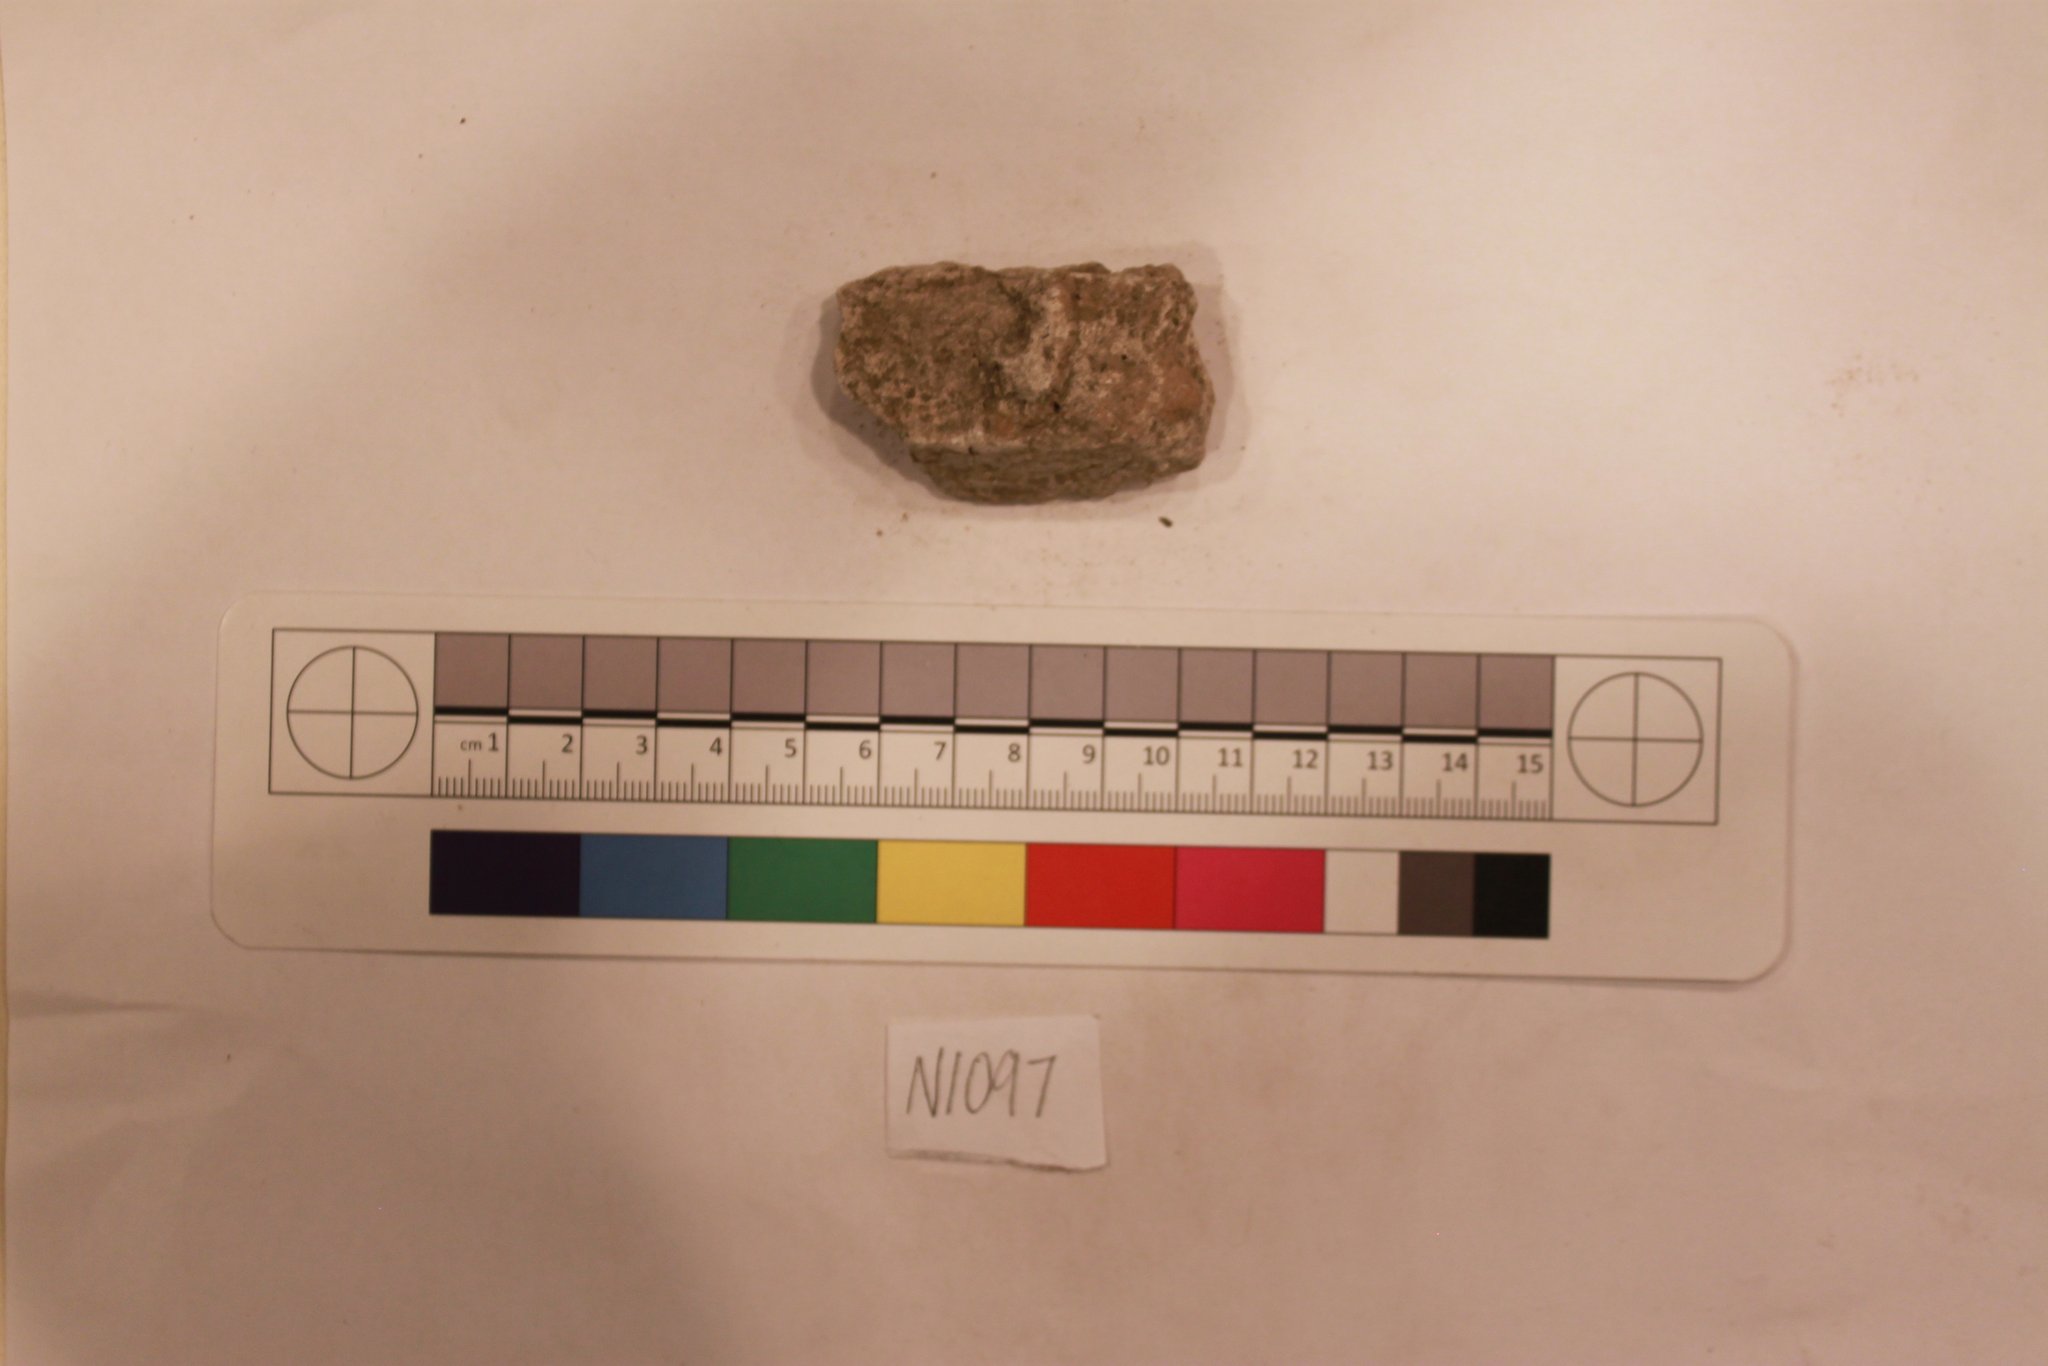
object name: fragment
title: Stucco Fragment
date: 701-1200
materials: plaster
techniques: carving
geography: iran